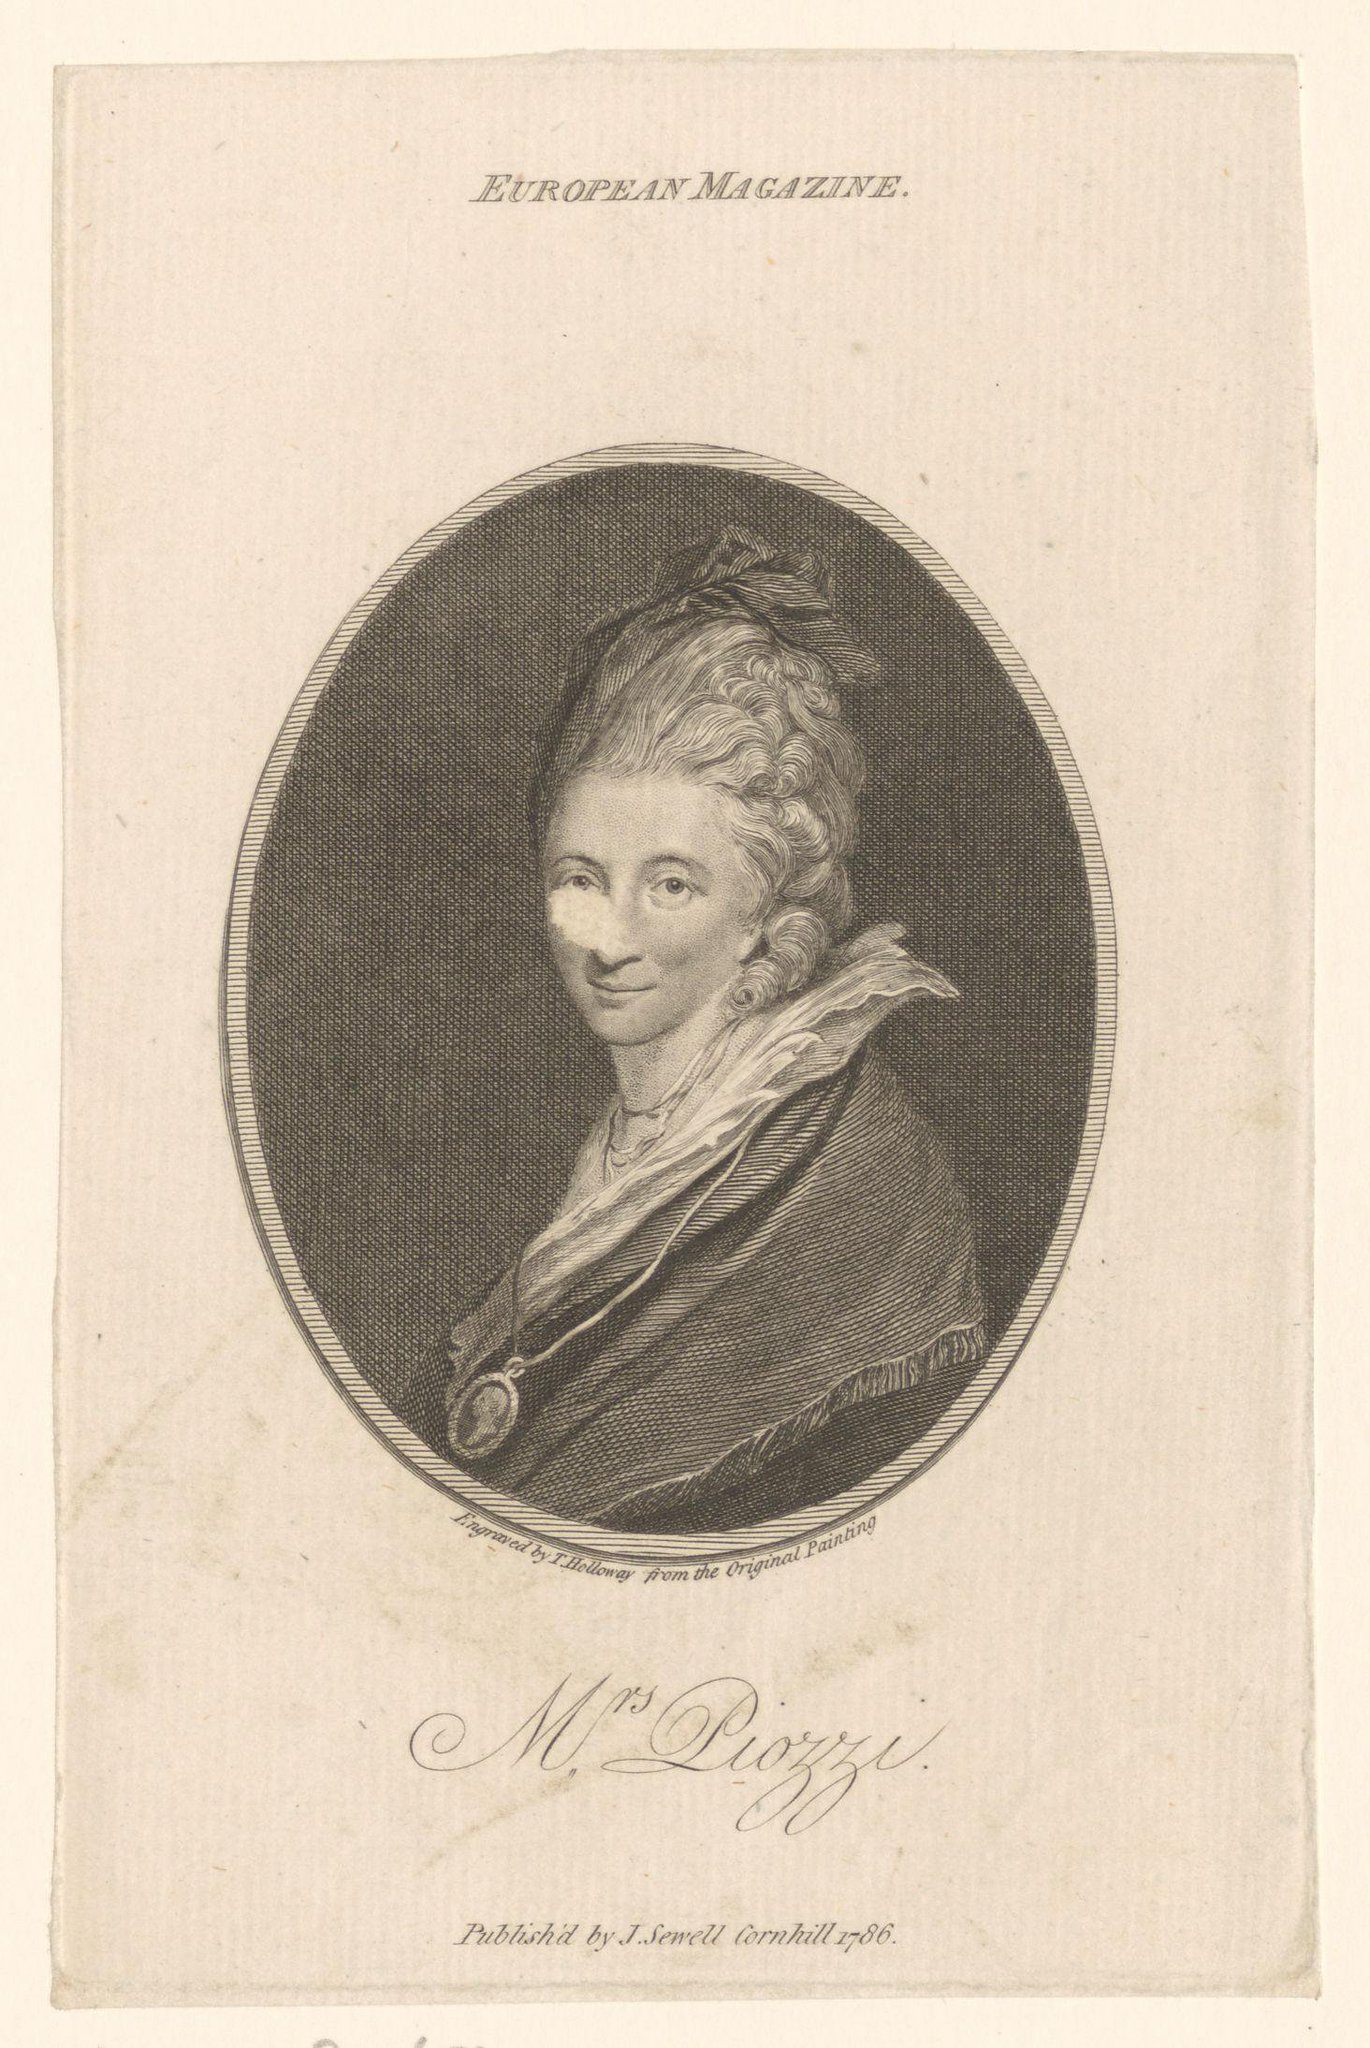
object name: print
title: Mrs. Piozzi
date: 1786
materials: paper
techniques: etching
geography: london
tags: historical persons - bb - woman, portrait of a writer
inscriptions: collector's mark: Lugt 2228